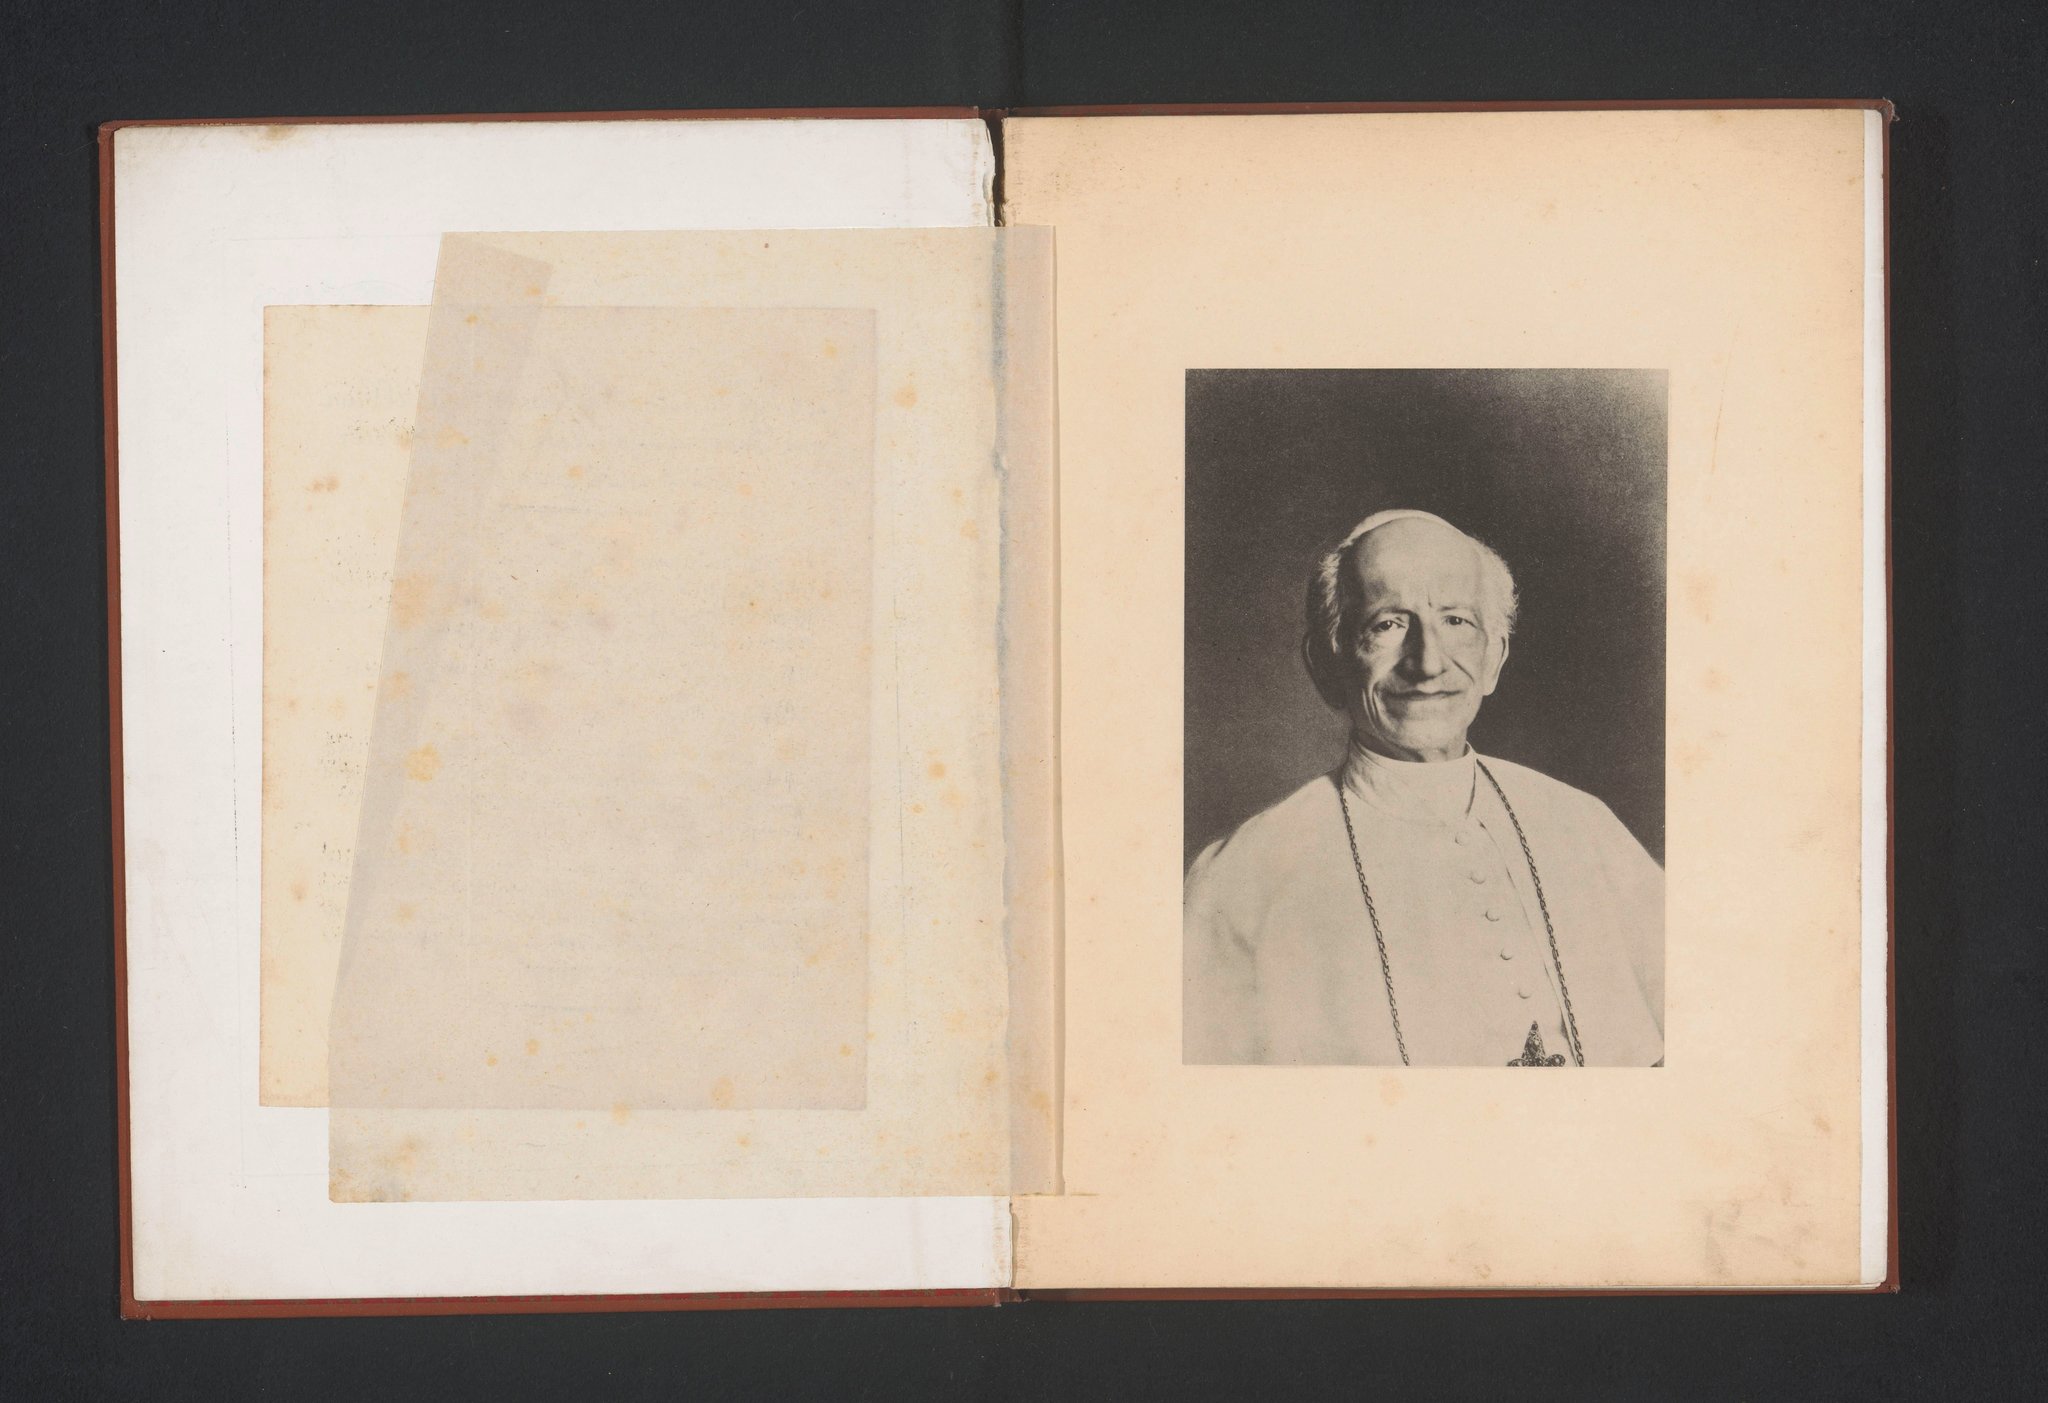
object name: photomechanical print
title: Portret van een onbekende man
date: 1893-1898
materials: paper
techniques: photograph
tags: historical persons not known by name